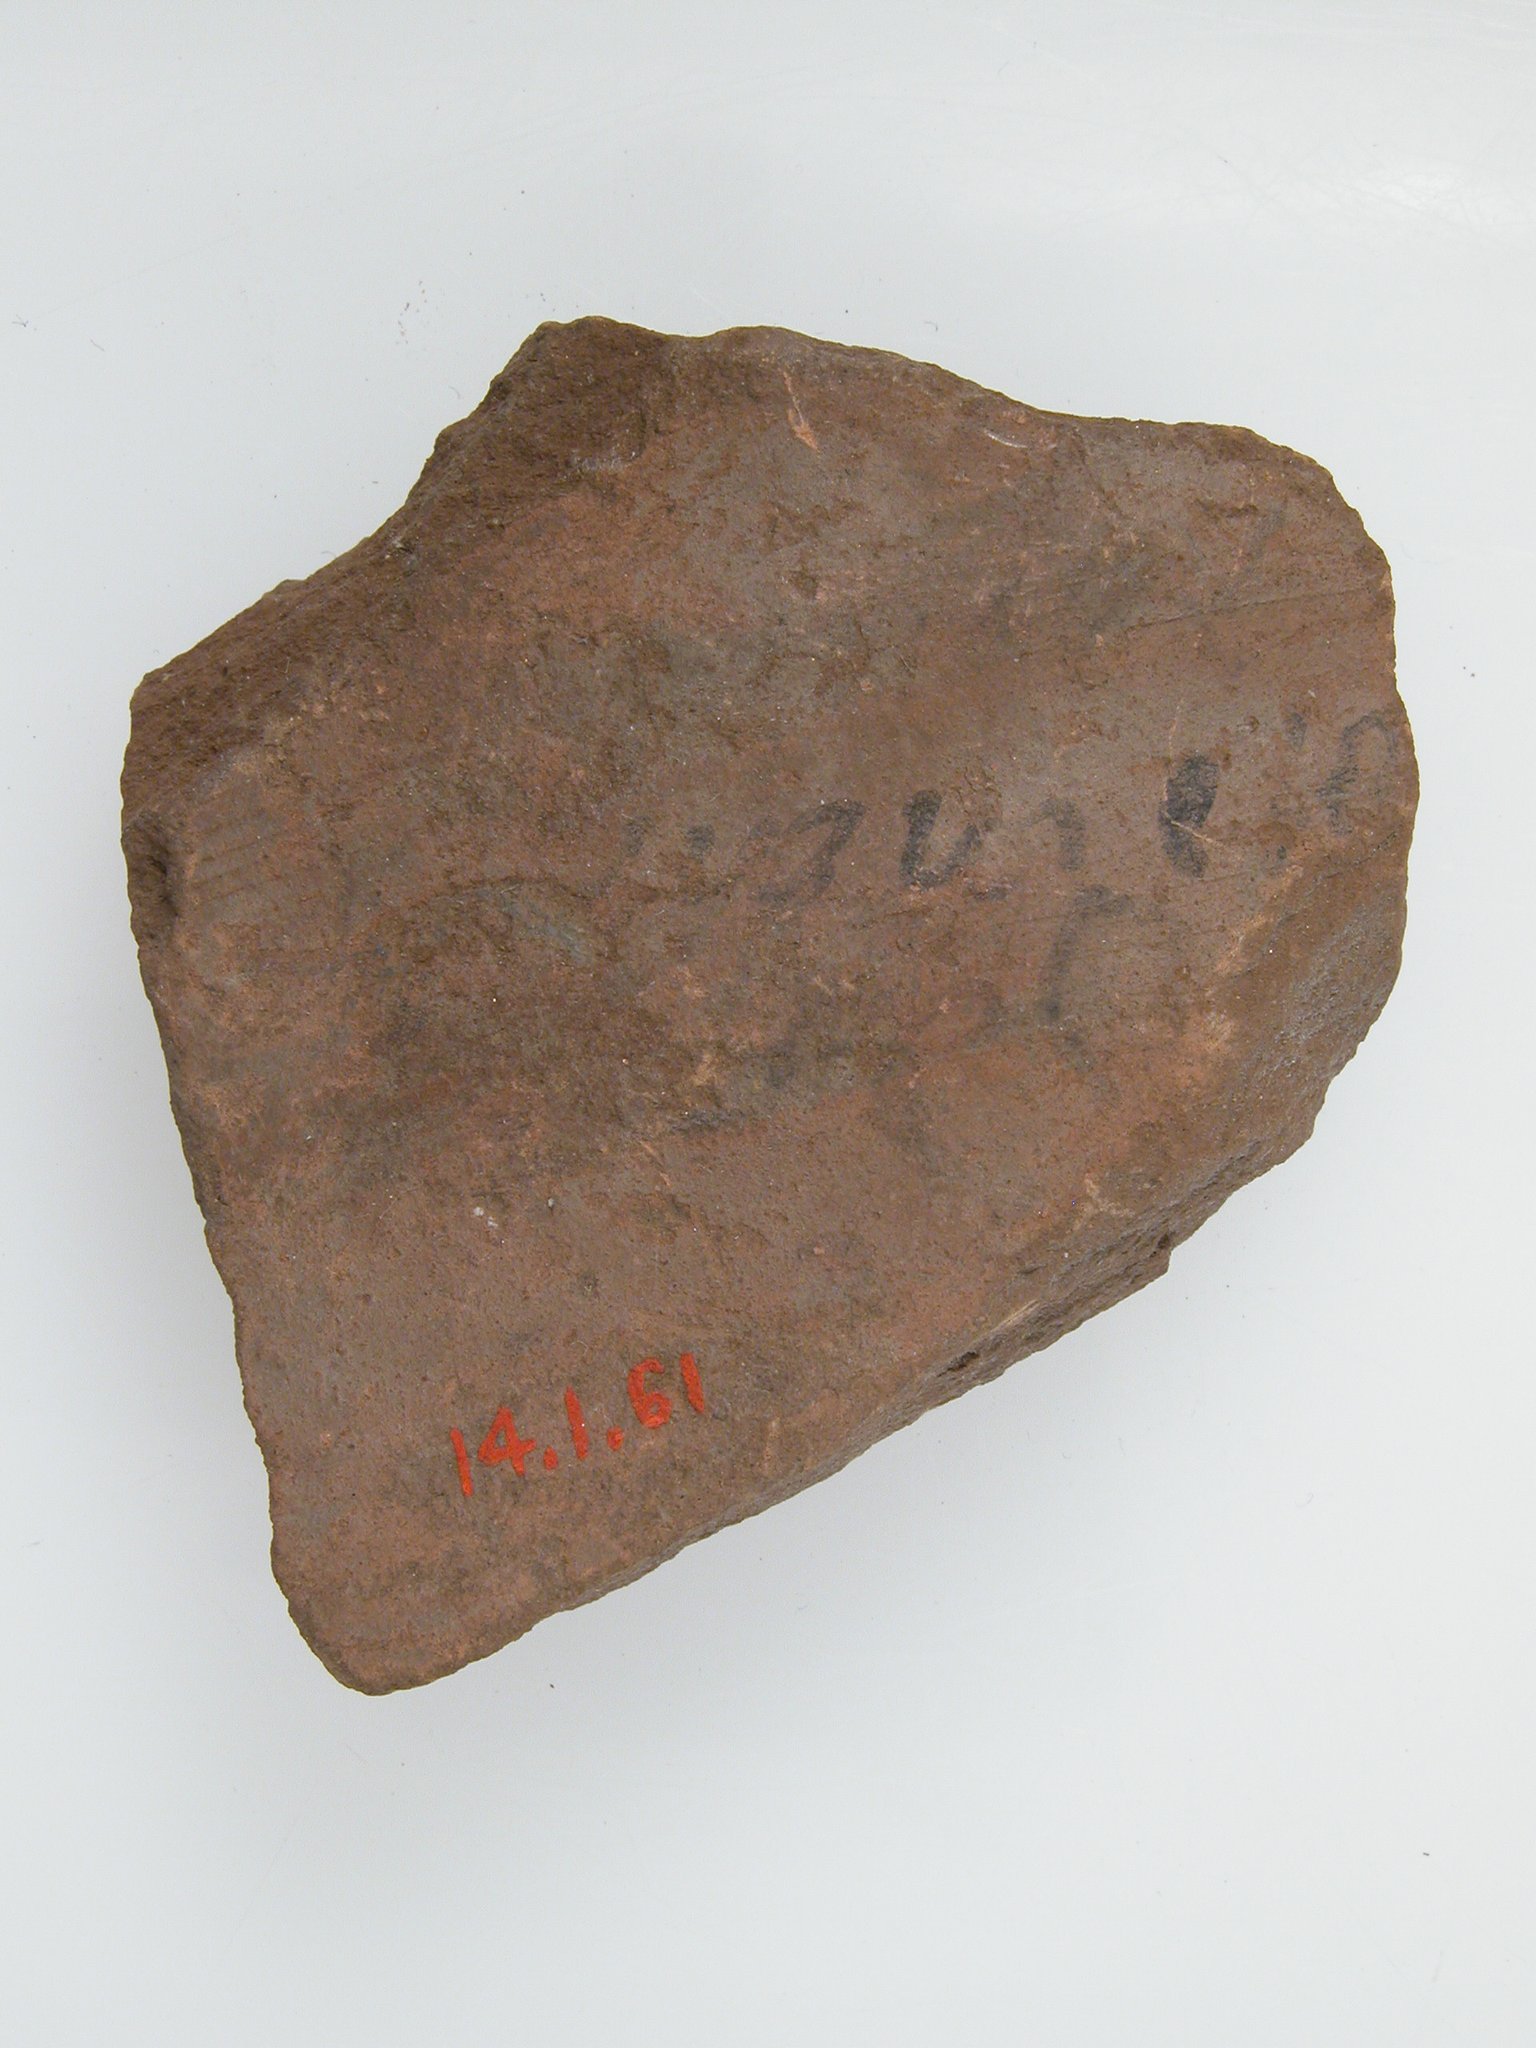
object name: ostrakon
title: Ostrakon with a Letter to Pesenthius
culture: coptic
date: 600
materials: ink, pottery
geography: egypt